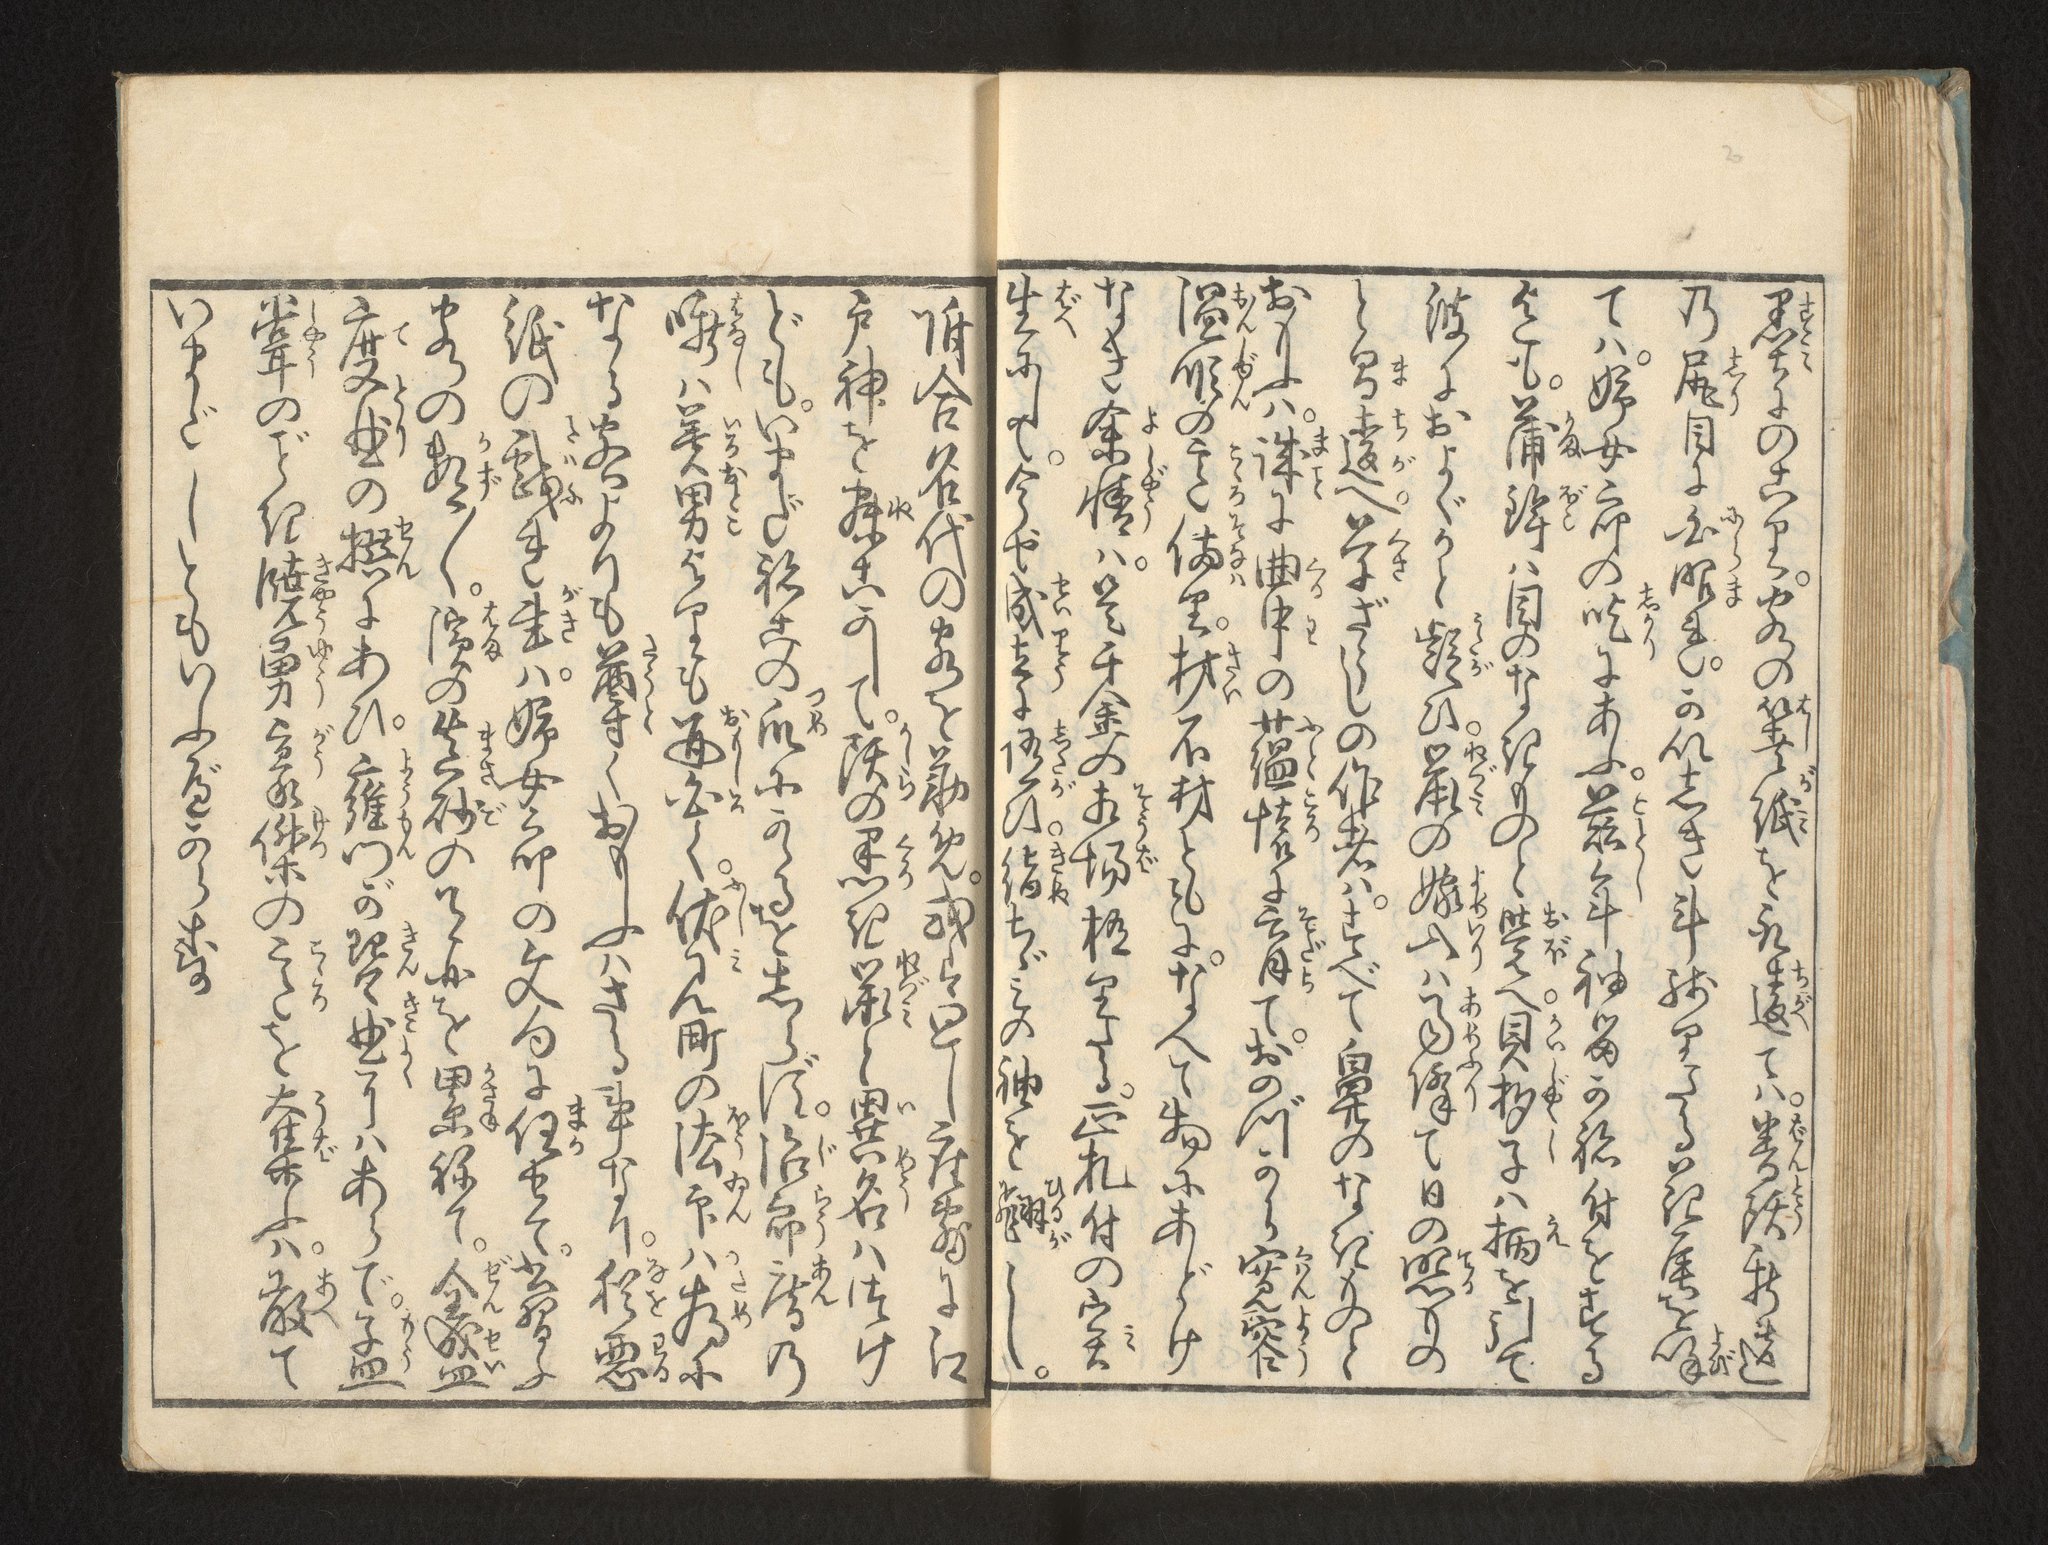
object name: page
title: Tekst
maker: jippensha ikku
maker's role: schrijver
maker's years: 1765-1831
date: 1804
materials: paper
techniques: woodcut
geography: edo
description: Pagina 38 en 39 van deel één van Utamaro`s boek: Gebeurtenissen in de lusthuizen gedurende het jaar.